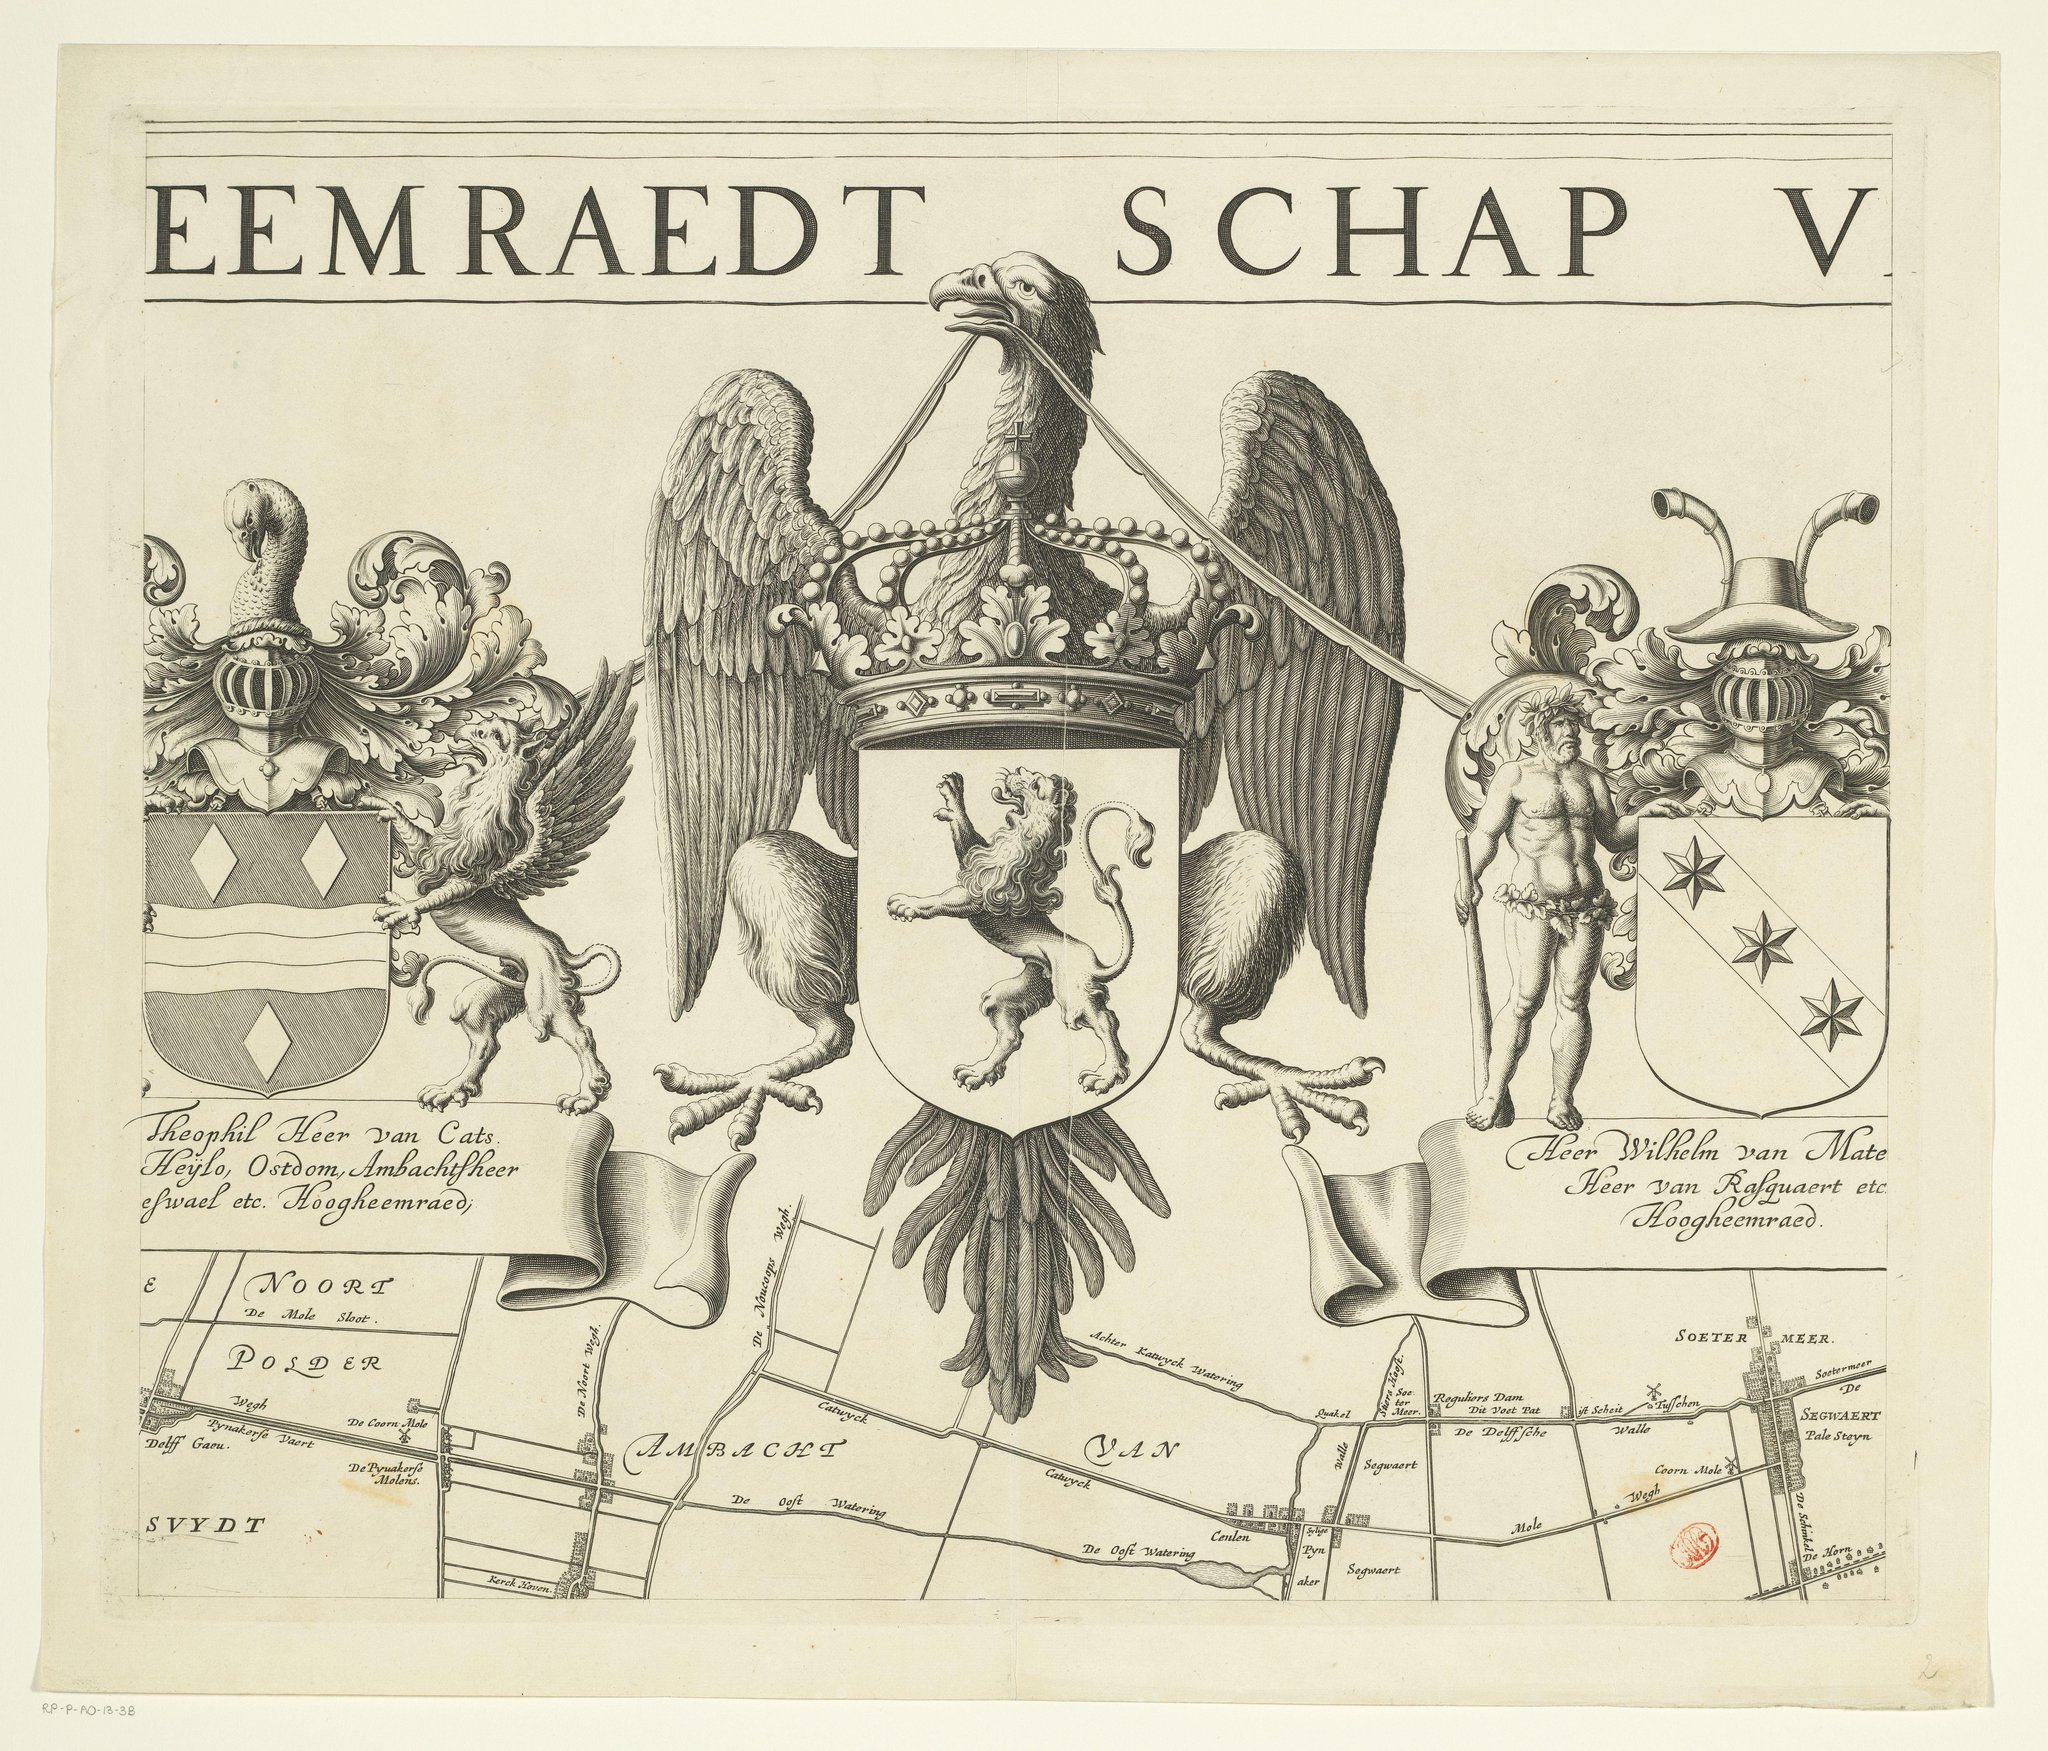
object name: print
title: Het Hooge Heemraedtschap van Schielandt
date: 1684-1718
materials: paper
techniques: engraving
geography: rotterdam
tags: coat of arms (as symbol of the state, etc.), maps of separate countries or regions, armorial bearing, heraldry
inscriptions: collector's mark: Lugt 2228, collector's mark: Lugt 195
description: Tweede deel van een kaart van het Hoogheemraadschap van Schieland bestaande uit negen delen.